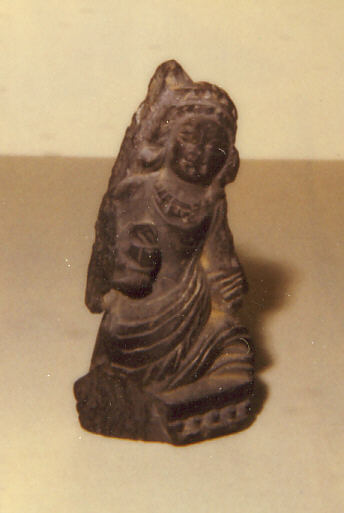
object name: figure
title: Seated or Kneeling Female Figure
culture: kashmiri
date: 501-800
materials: stone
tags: kashmir